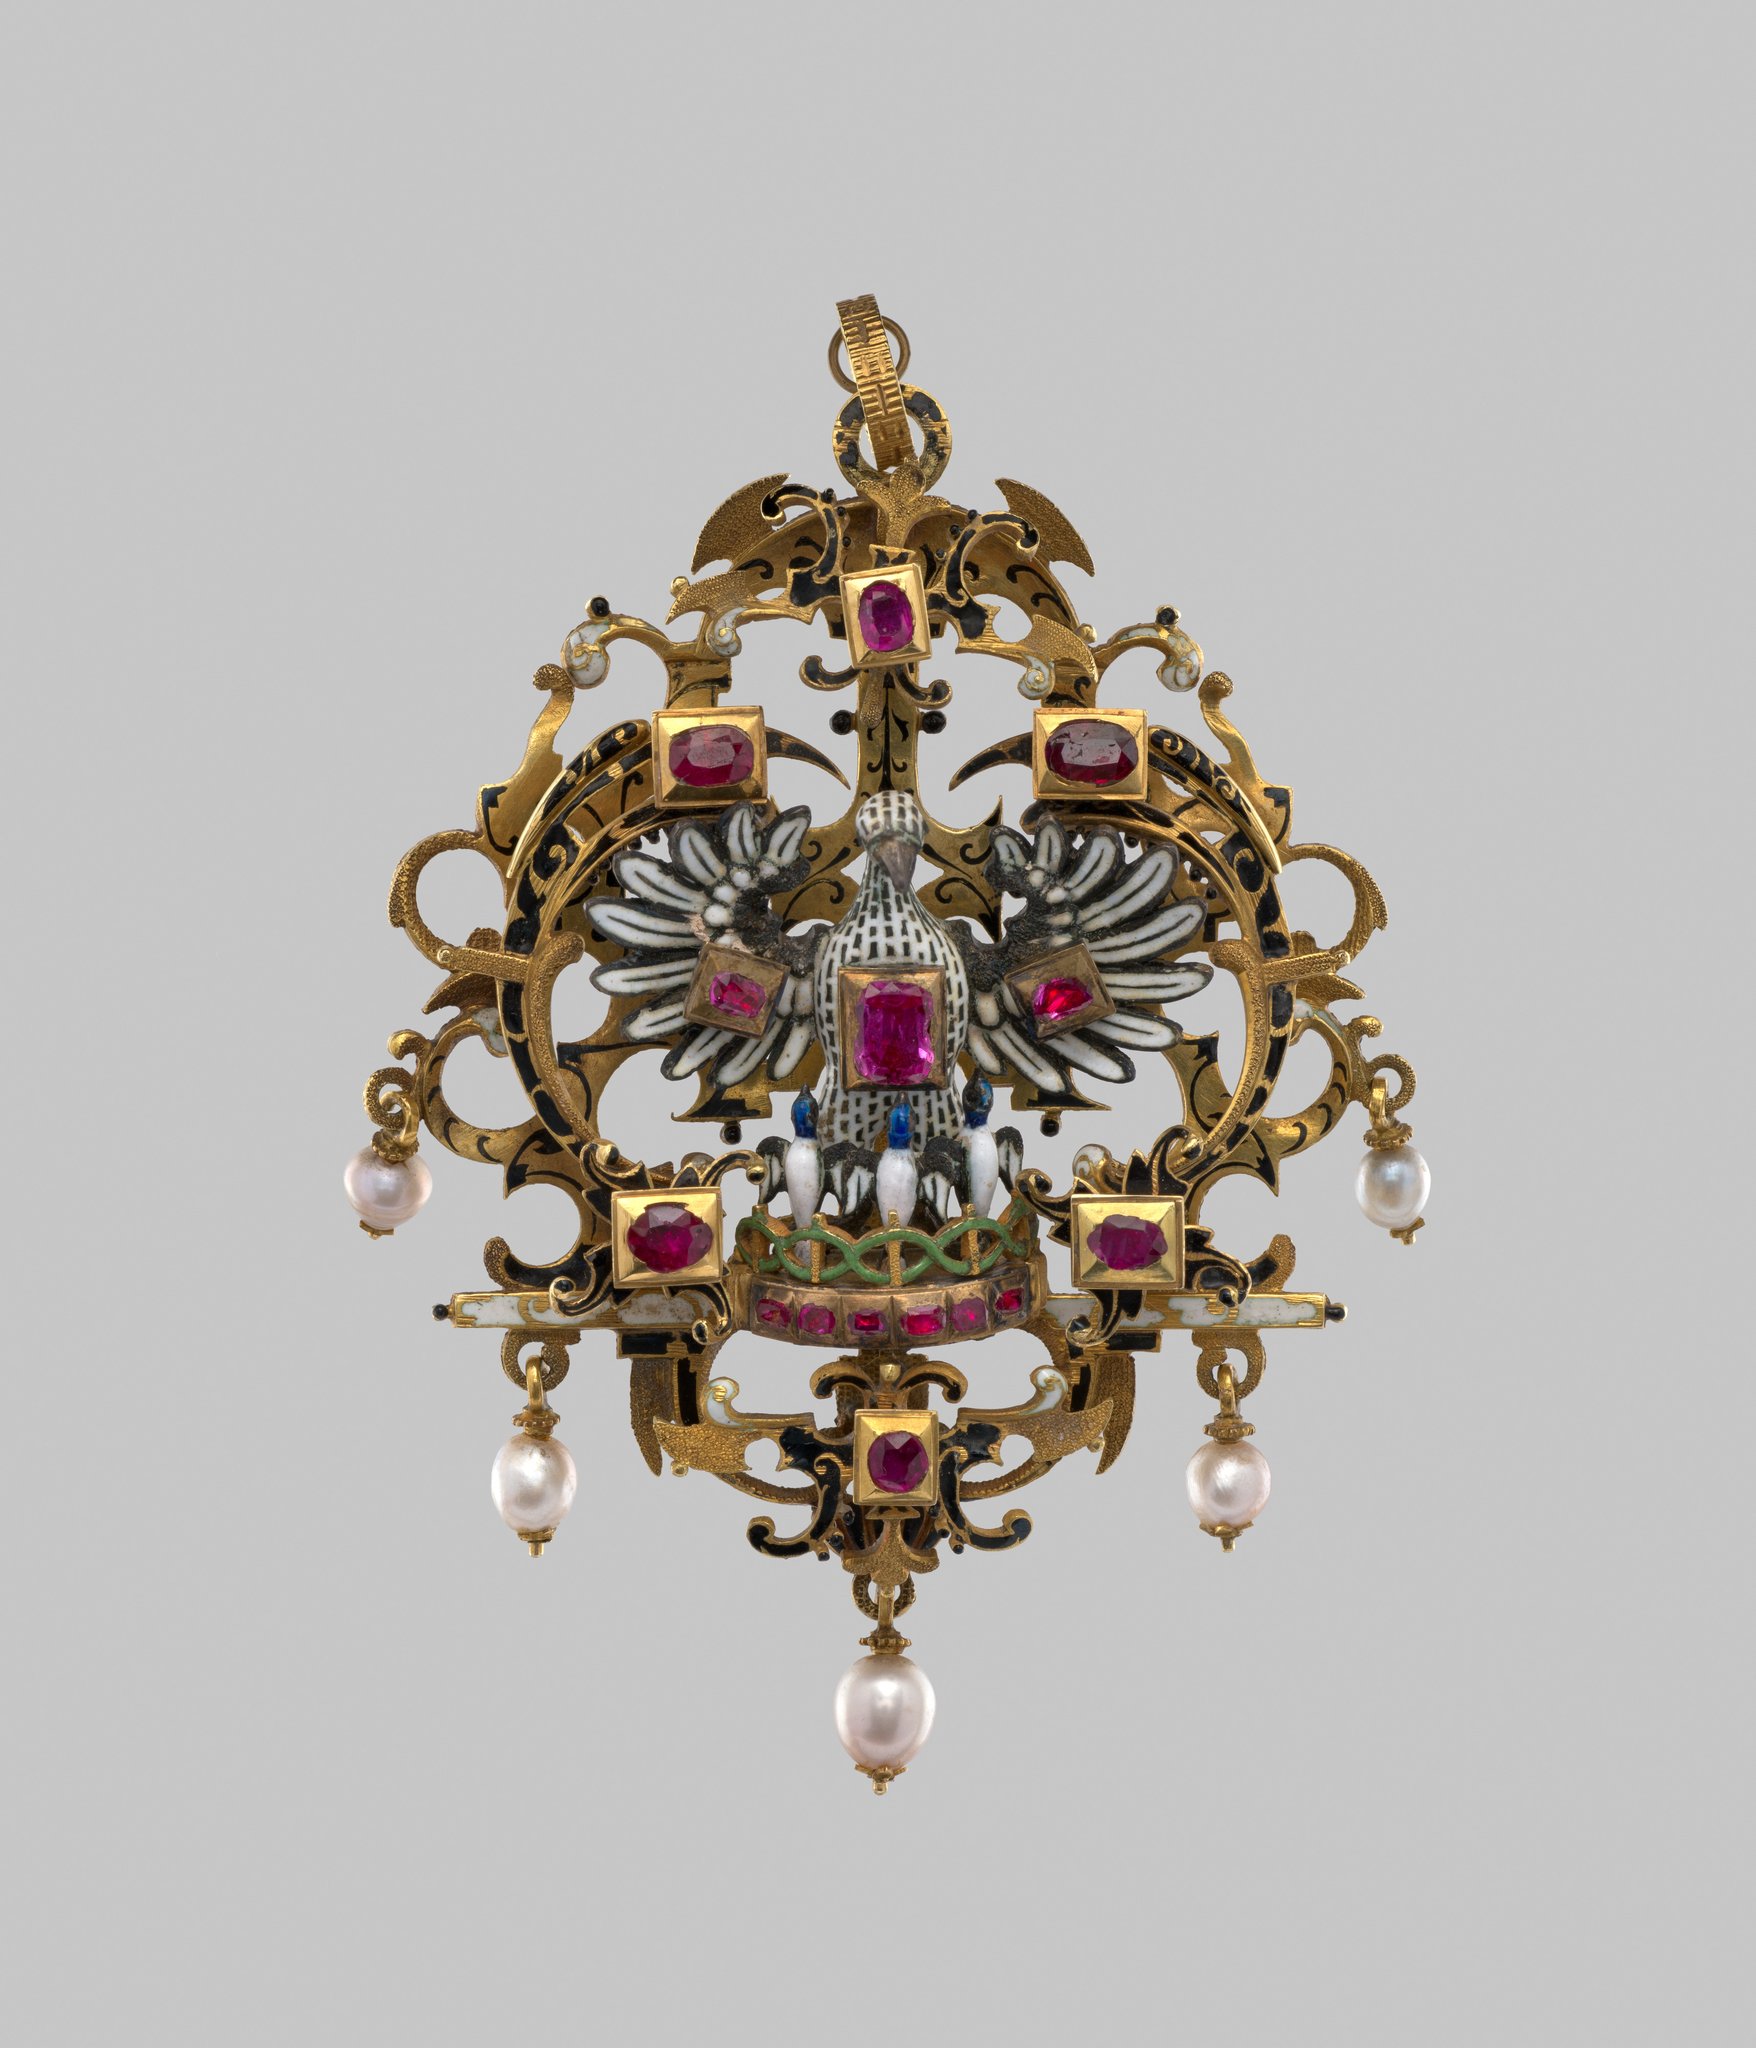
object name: pendant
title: Pendant of Pelican-in-her-piety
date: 1801-1900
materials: enamel, gold, pearl, gemstone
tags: birds